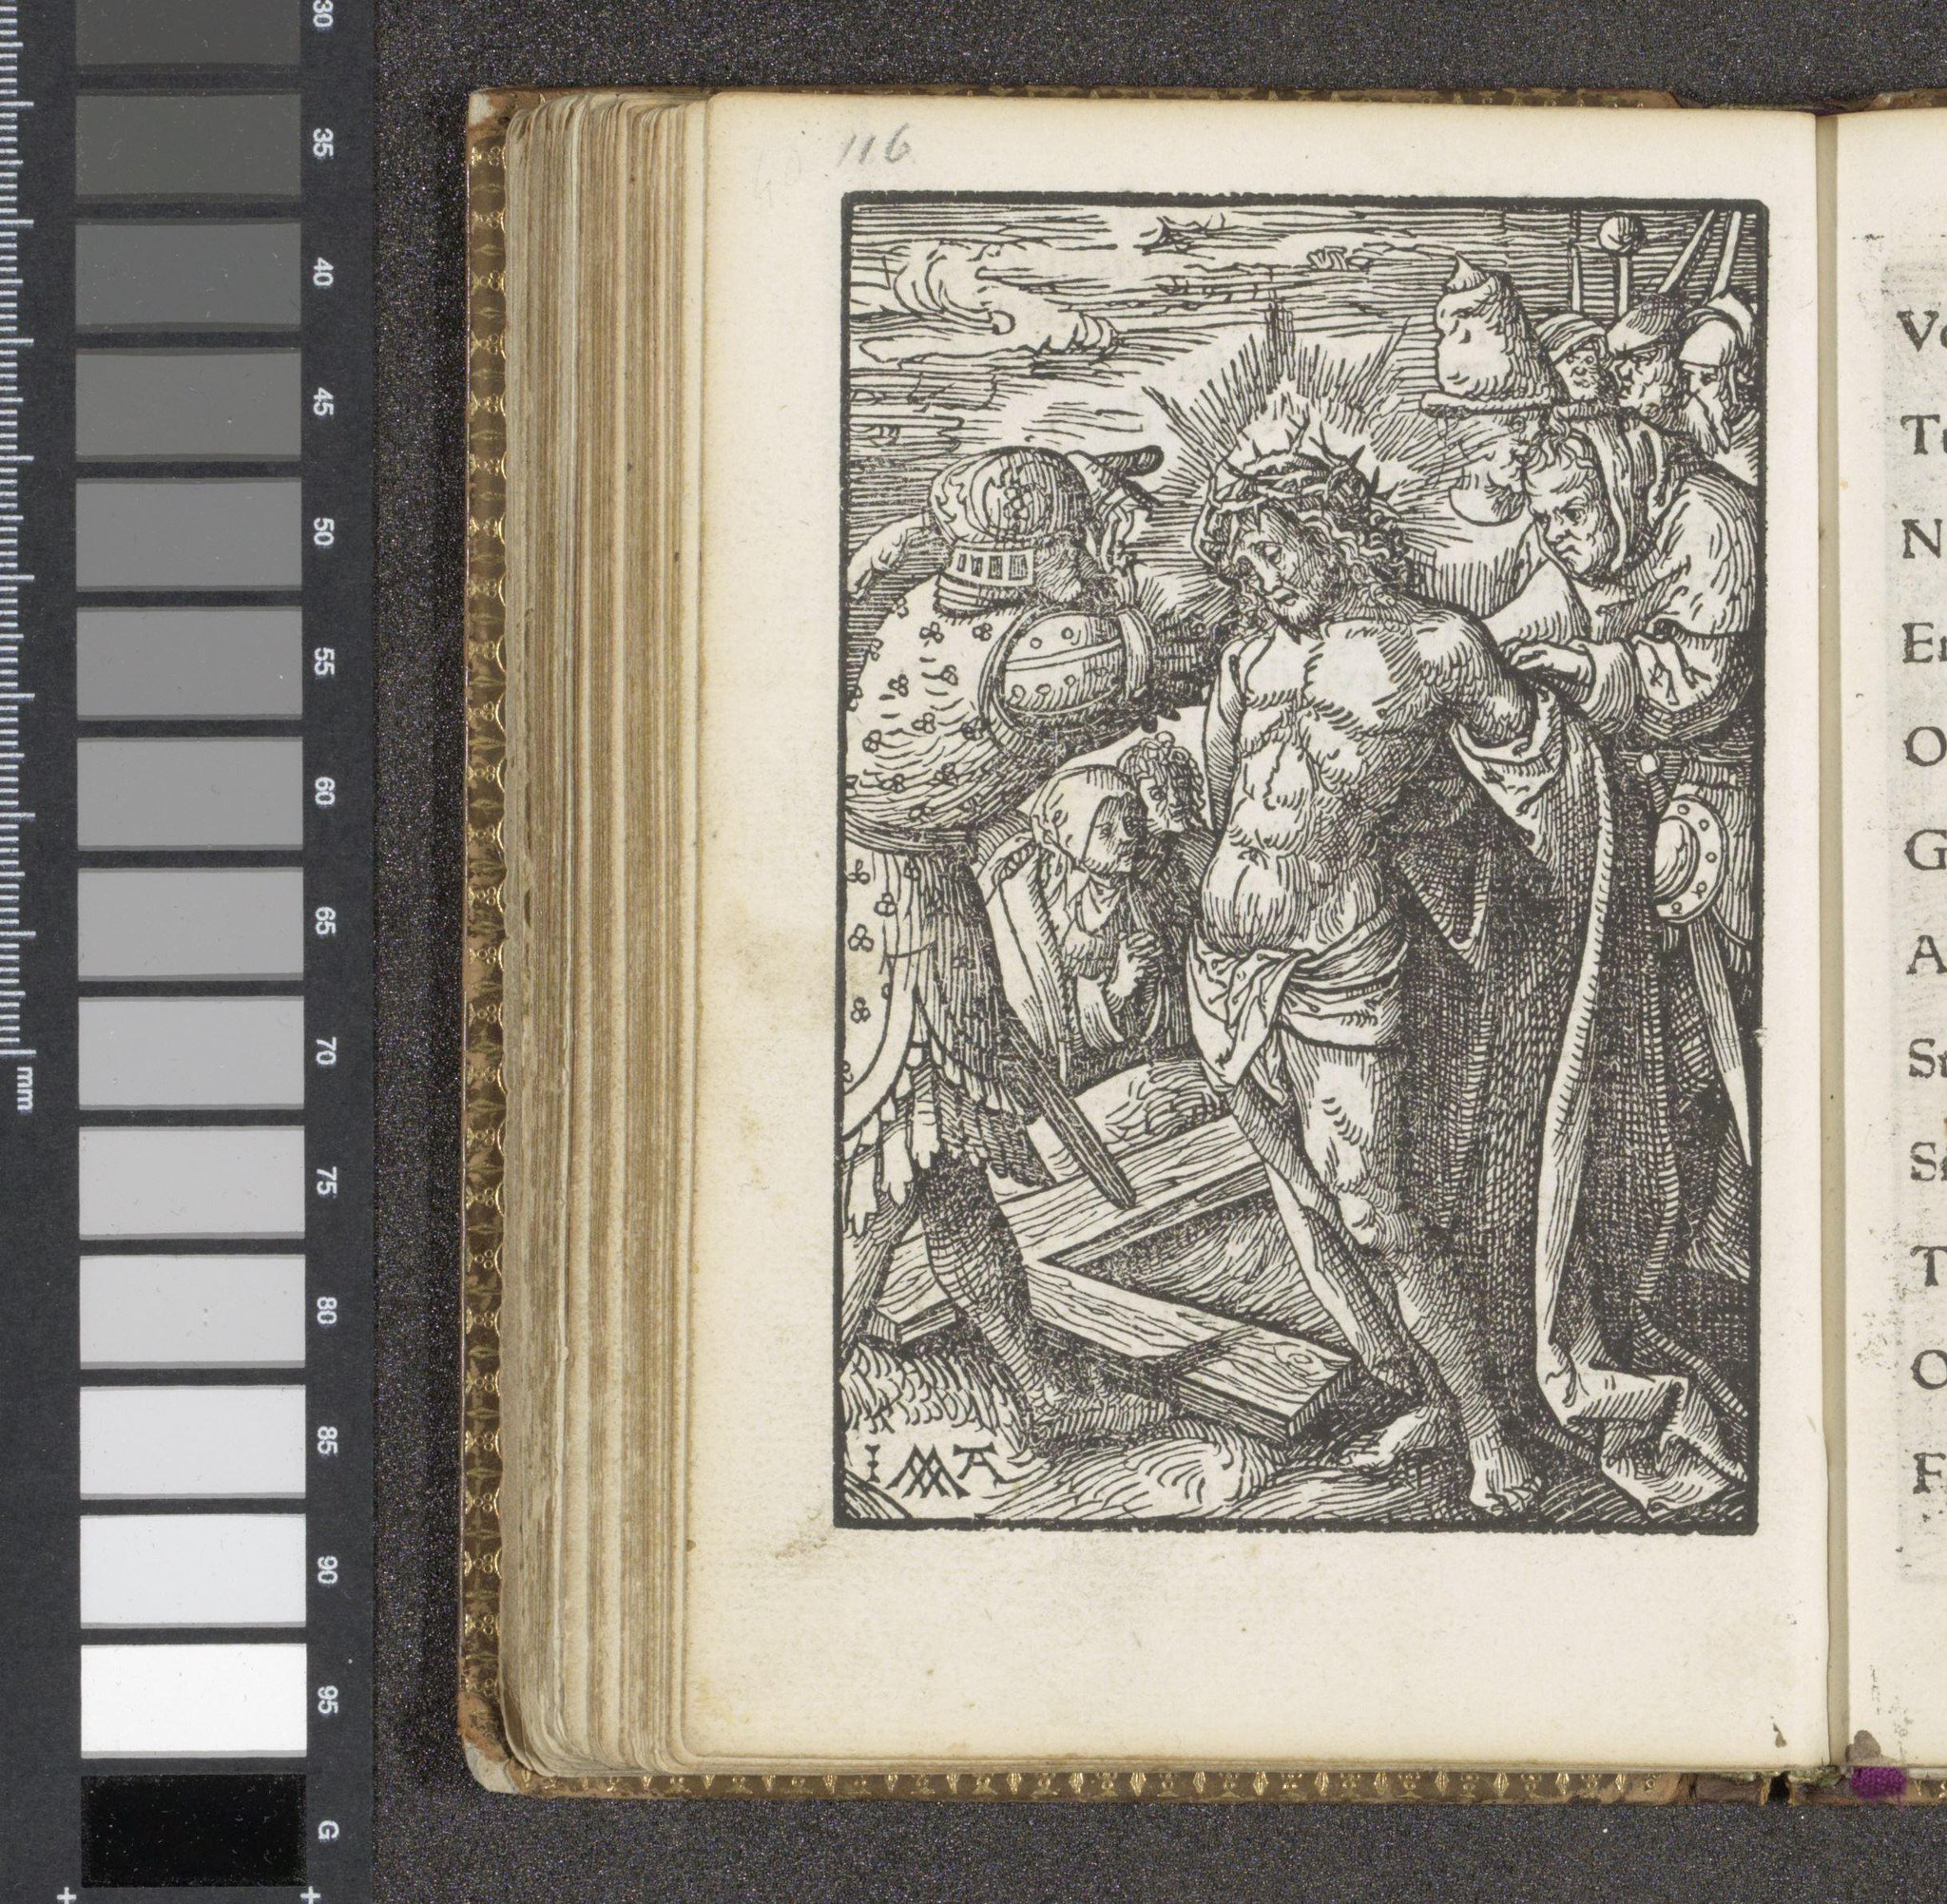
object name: book illustration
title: Christus wordt zijn mantel afgenomen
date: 1523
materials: paper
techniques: woodcut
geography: amsterdam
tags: christ disrobed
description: Christus staat bij het kruis met de doornenkroon op zijn hoofd. Het kruis ligt klaar. Een man trekt Christus zijn mantel uit. Een andere man slaat Christus. Maria en Johannes kijken toe. Prent maakt deel uit van een boek.